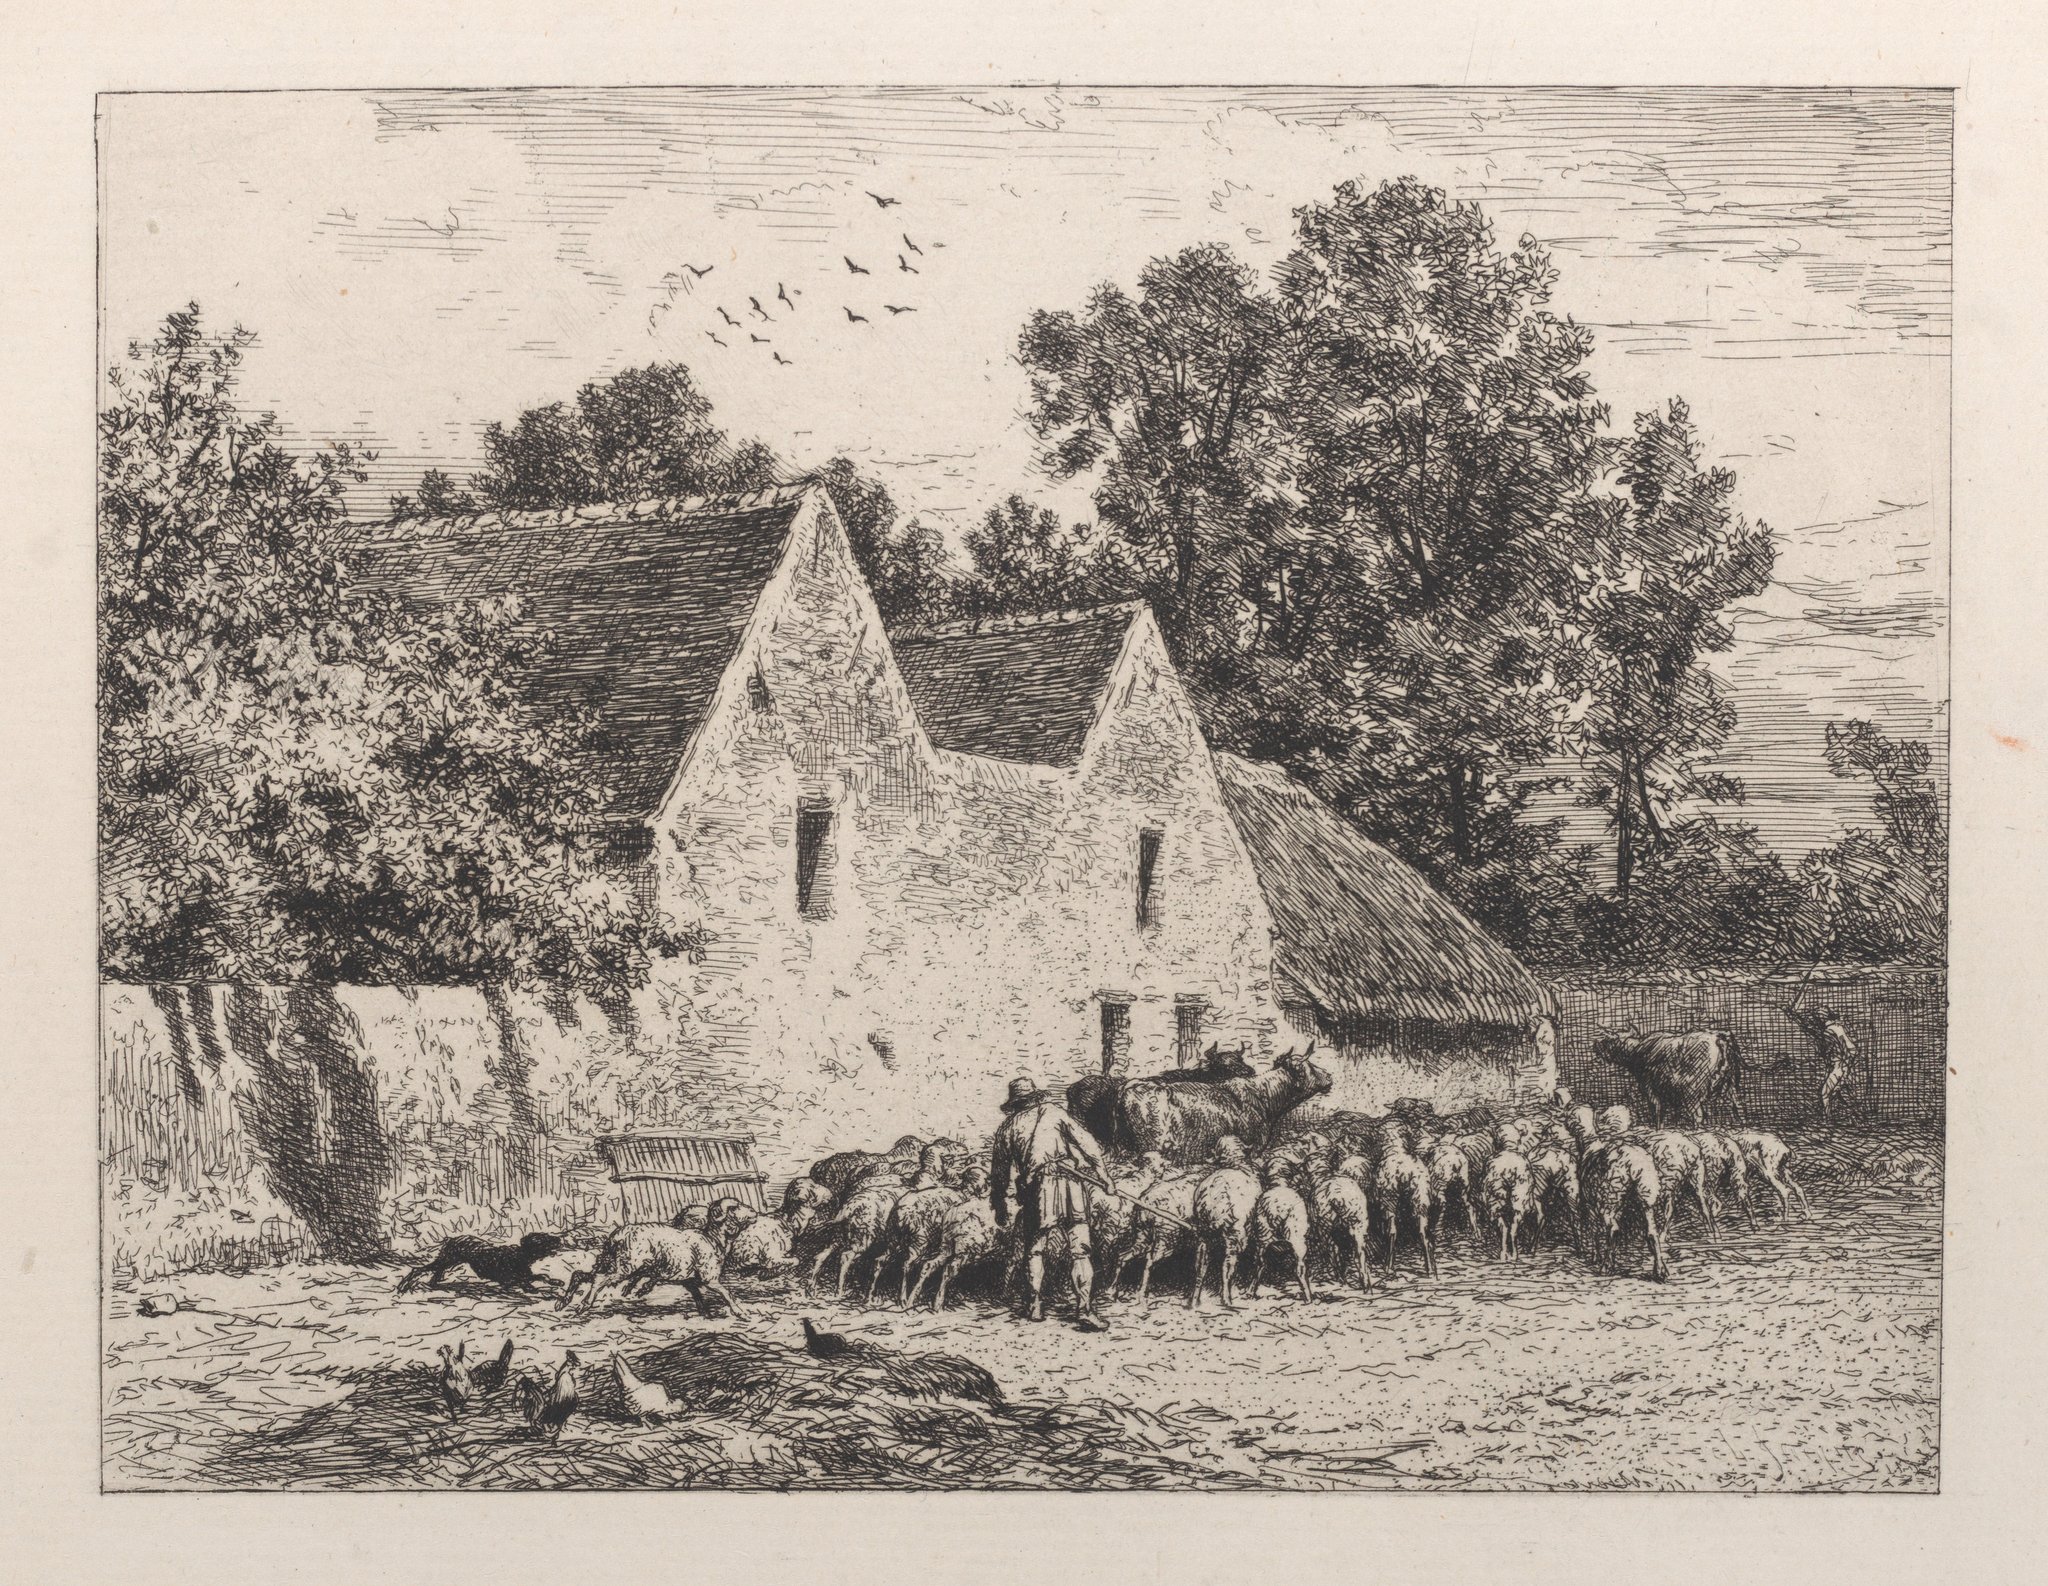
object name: print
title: A Farm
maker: charles émile jacque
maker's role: artist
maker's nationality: french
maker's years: 1813-1894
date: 1864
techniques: etching